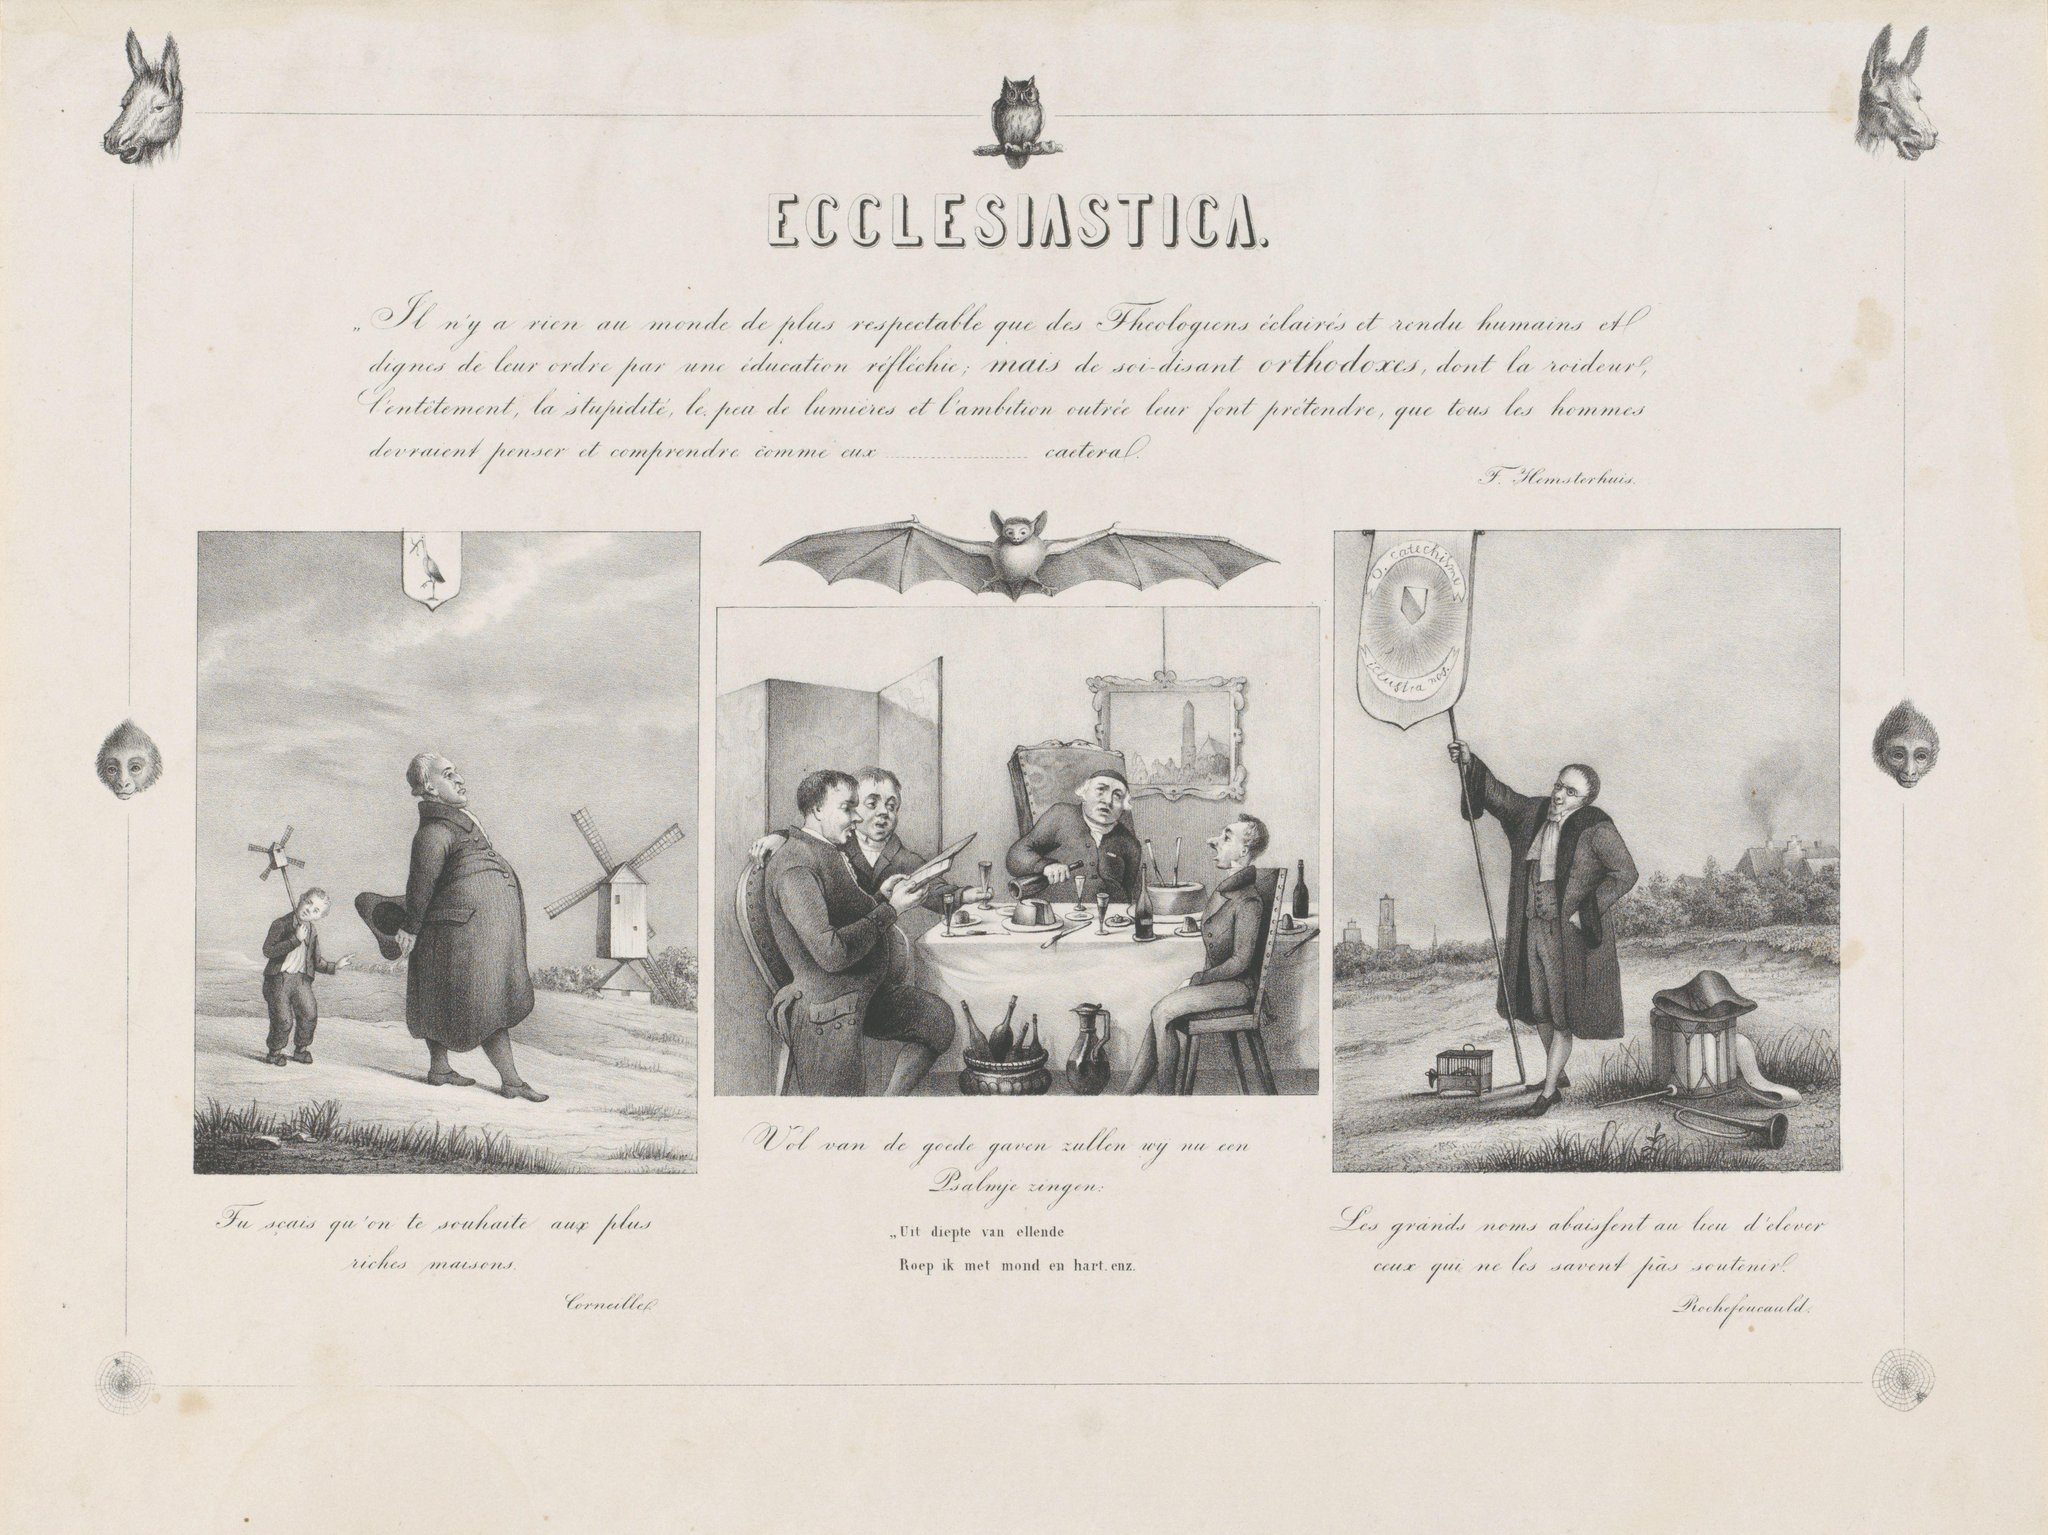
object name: cartoon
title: Spotprent op drie predikanten, ca. 1853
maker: Anonymous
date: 1851-1855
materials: paper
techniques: lithograph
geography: netherlands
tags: (aspects of) christian religion or the church (as institution) ridiculed, criticized, or caricaturized, functionaries and dignitaries ~ protestant churches, the hague, utrecht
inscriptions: collector's mark: Lugt 2228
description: Spotprent op drie verschillende predikanten, ca. 1853. Links de Haagse predikant Dirk Molenaar, wandelend langs een windmolen. Centraal de Utrechtse predikant Lucas Merens, met drie anderen zittend aan een goed gevulde tafel. Boven deze scène een vleermuis. Rechts de Utrechtse hervormde predikant en hoogleraar H.E. Vinke, met vogelkooitje, vaandel , trom en trompet. Bovenaan een vierregelig citaat uit F. Hemsterhuis, ook met onderschriften onder de drie afzonderlijke voorstellingen. Het geheel in een kader versierd met koppen van dieren en spinnenwebben.